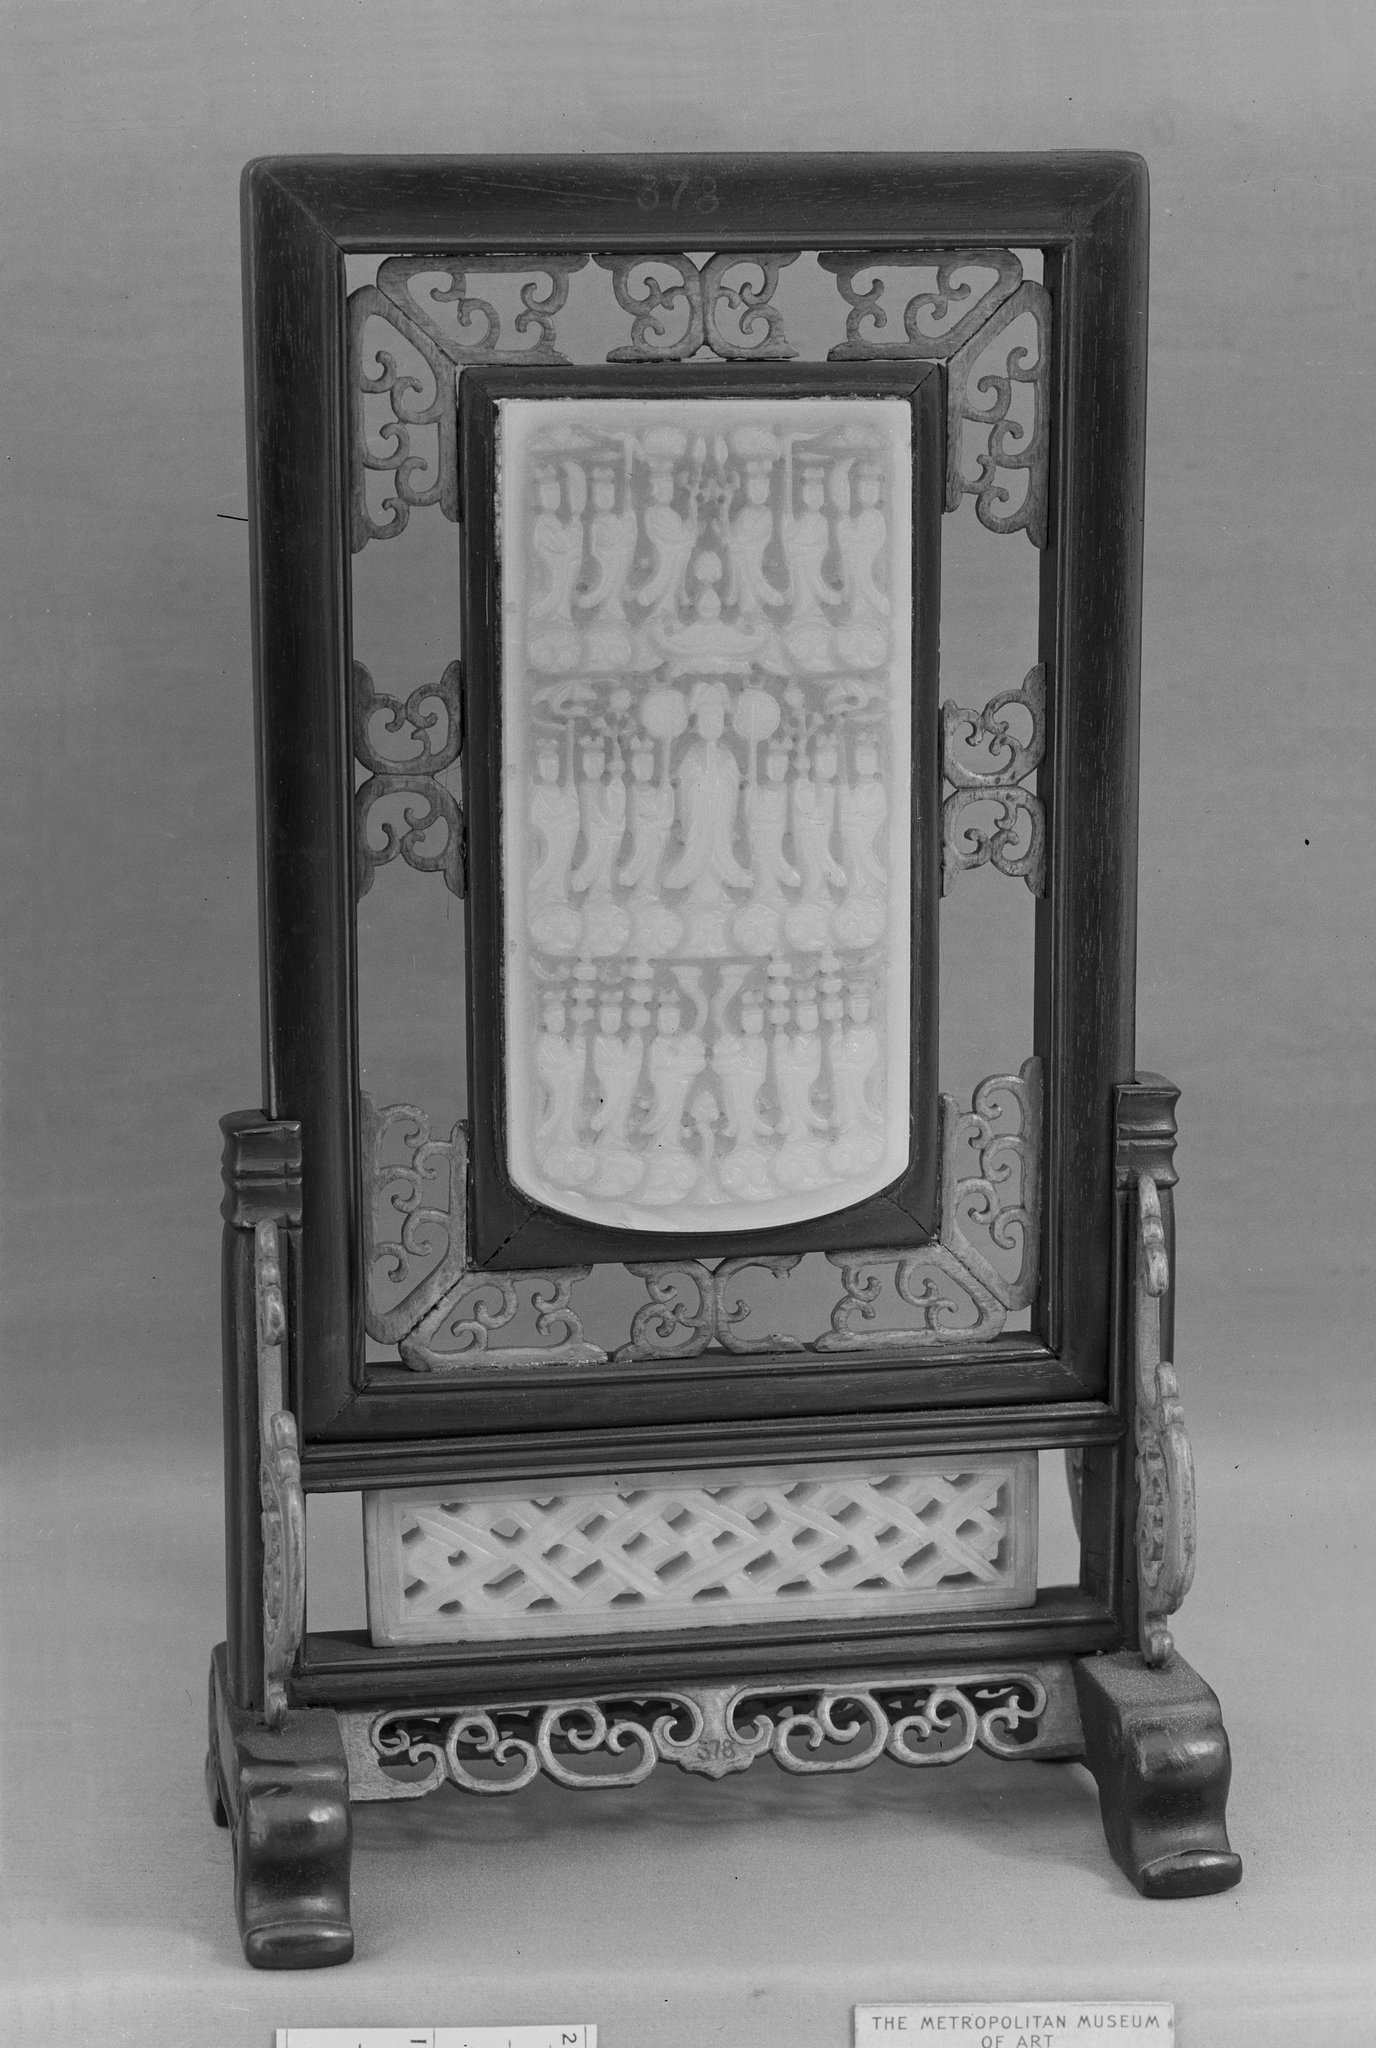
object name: table screen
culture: chinese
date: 1368-1644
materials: jade